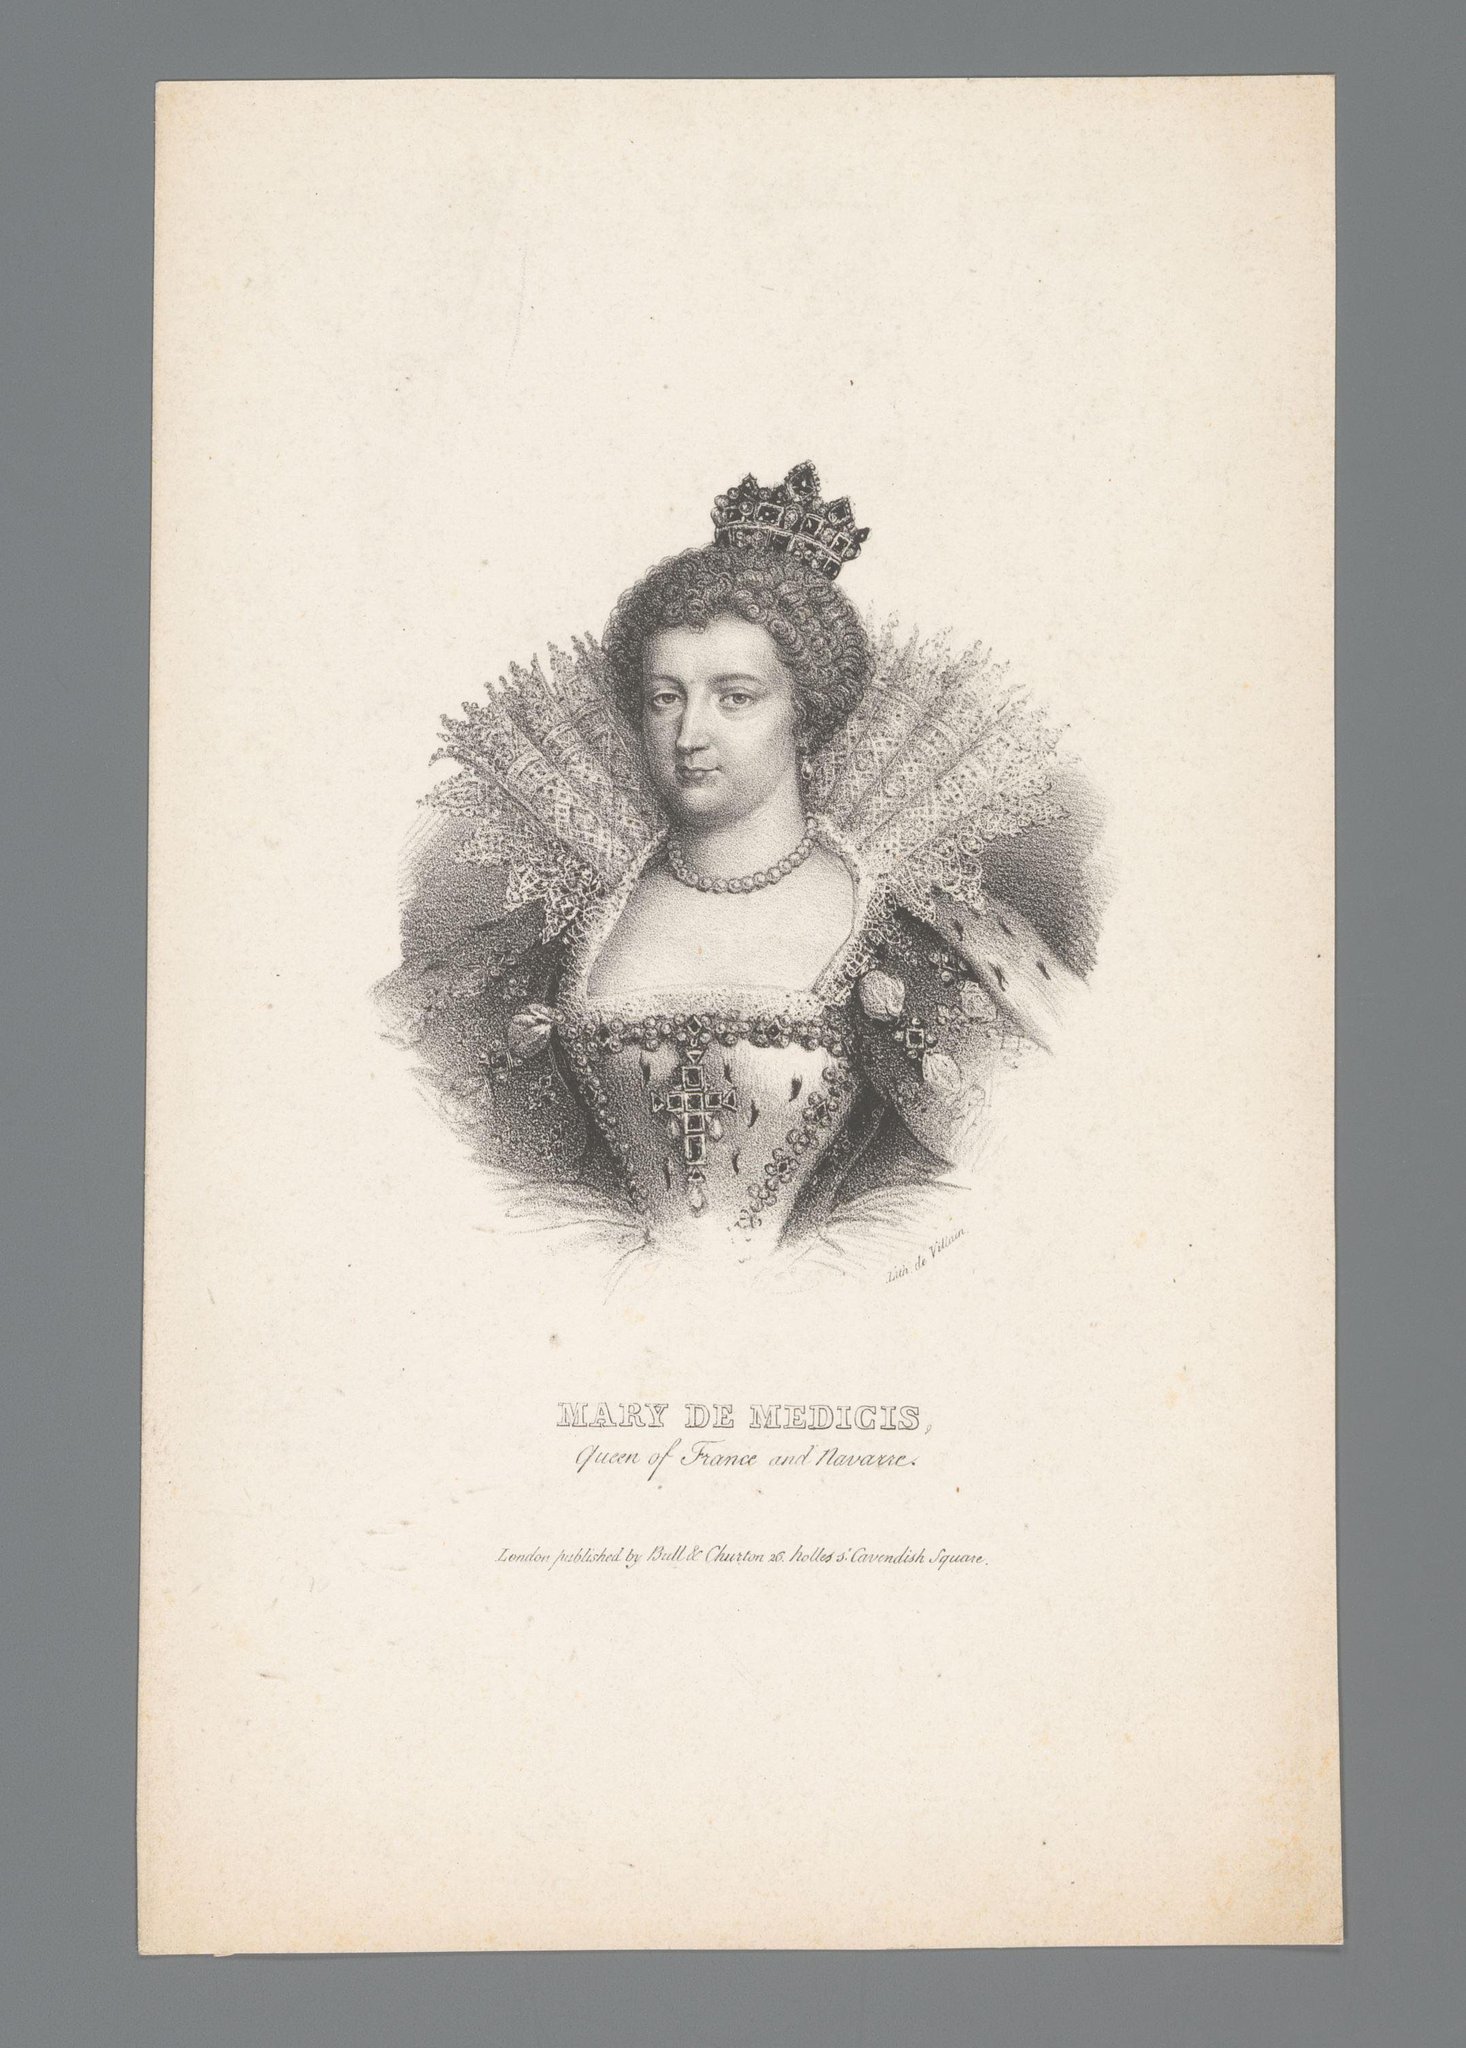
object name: print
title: Mary de Medicis, queen of France and Navarre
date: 1818-1852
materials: paper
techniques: lithograph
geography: london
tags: cologne, print maker, maria de' medici, historical persons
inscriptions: collector's mark: Lugt 2228